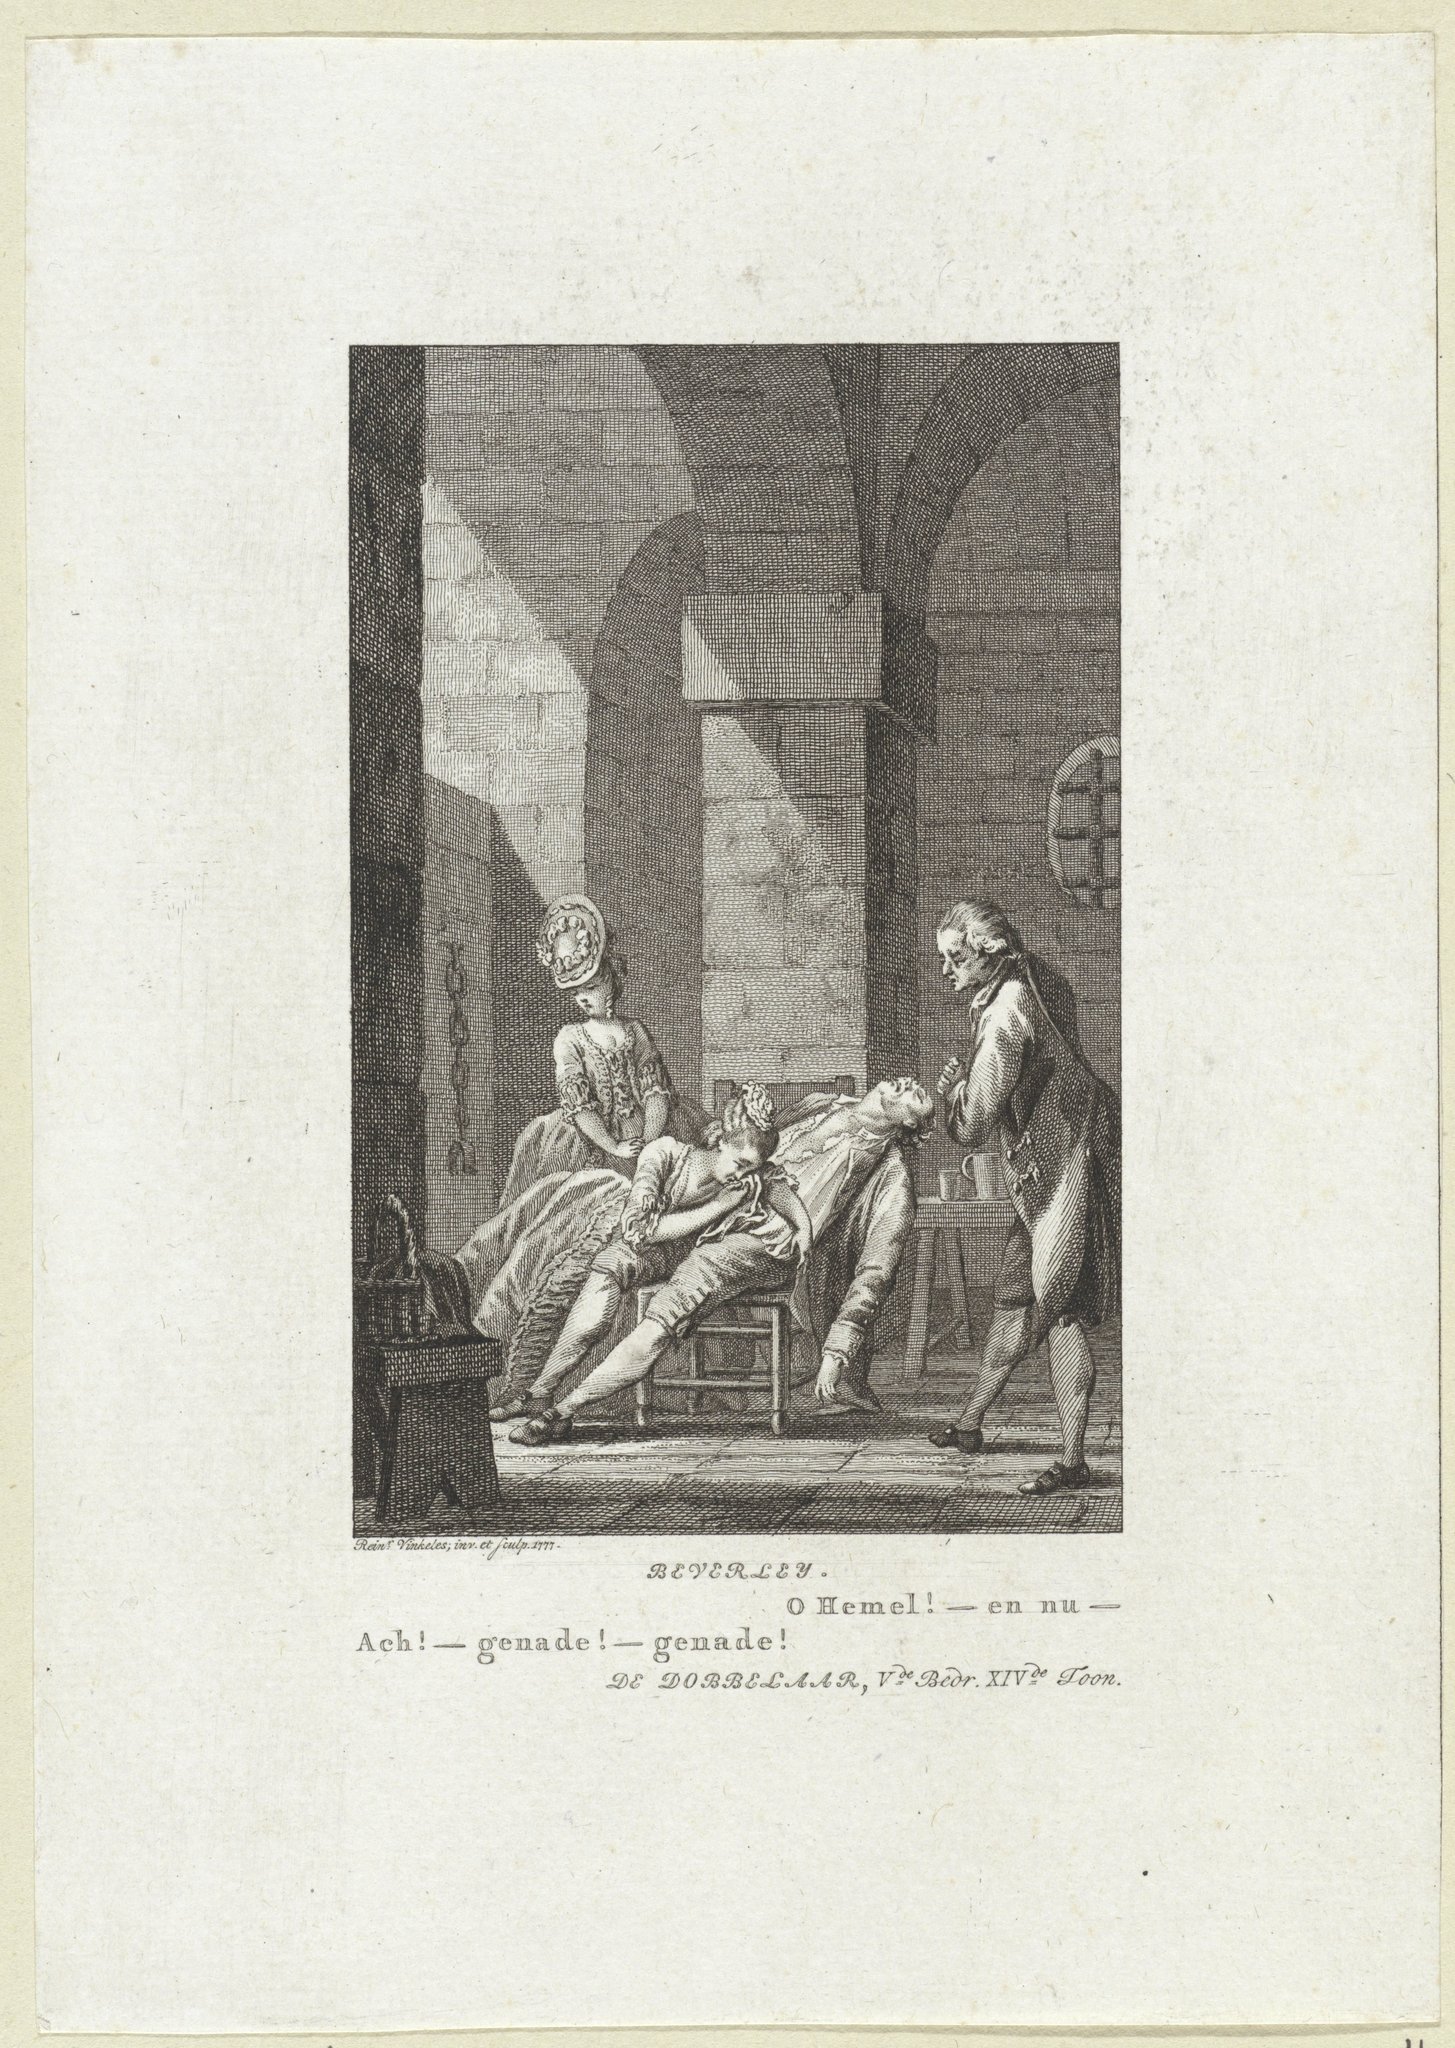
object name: print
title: Vrouw huilt in de schoot van een man die buiten bewustzijn is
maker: reinier vinkeles (i)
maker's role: draughtsman, print maker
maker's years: 1741-1816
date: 1777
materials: paper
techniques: engraving, etching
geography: amsterdam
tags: prison, jail, fainting, swooning, weeping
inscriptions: collector's mark: Lugt 240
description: In een cel huilt een vrouw in de schoot van een man die buiten bewustzijn is. Een man en een vrouw kijken toe.